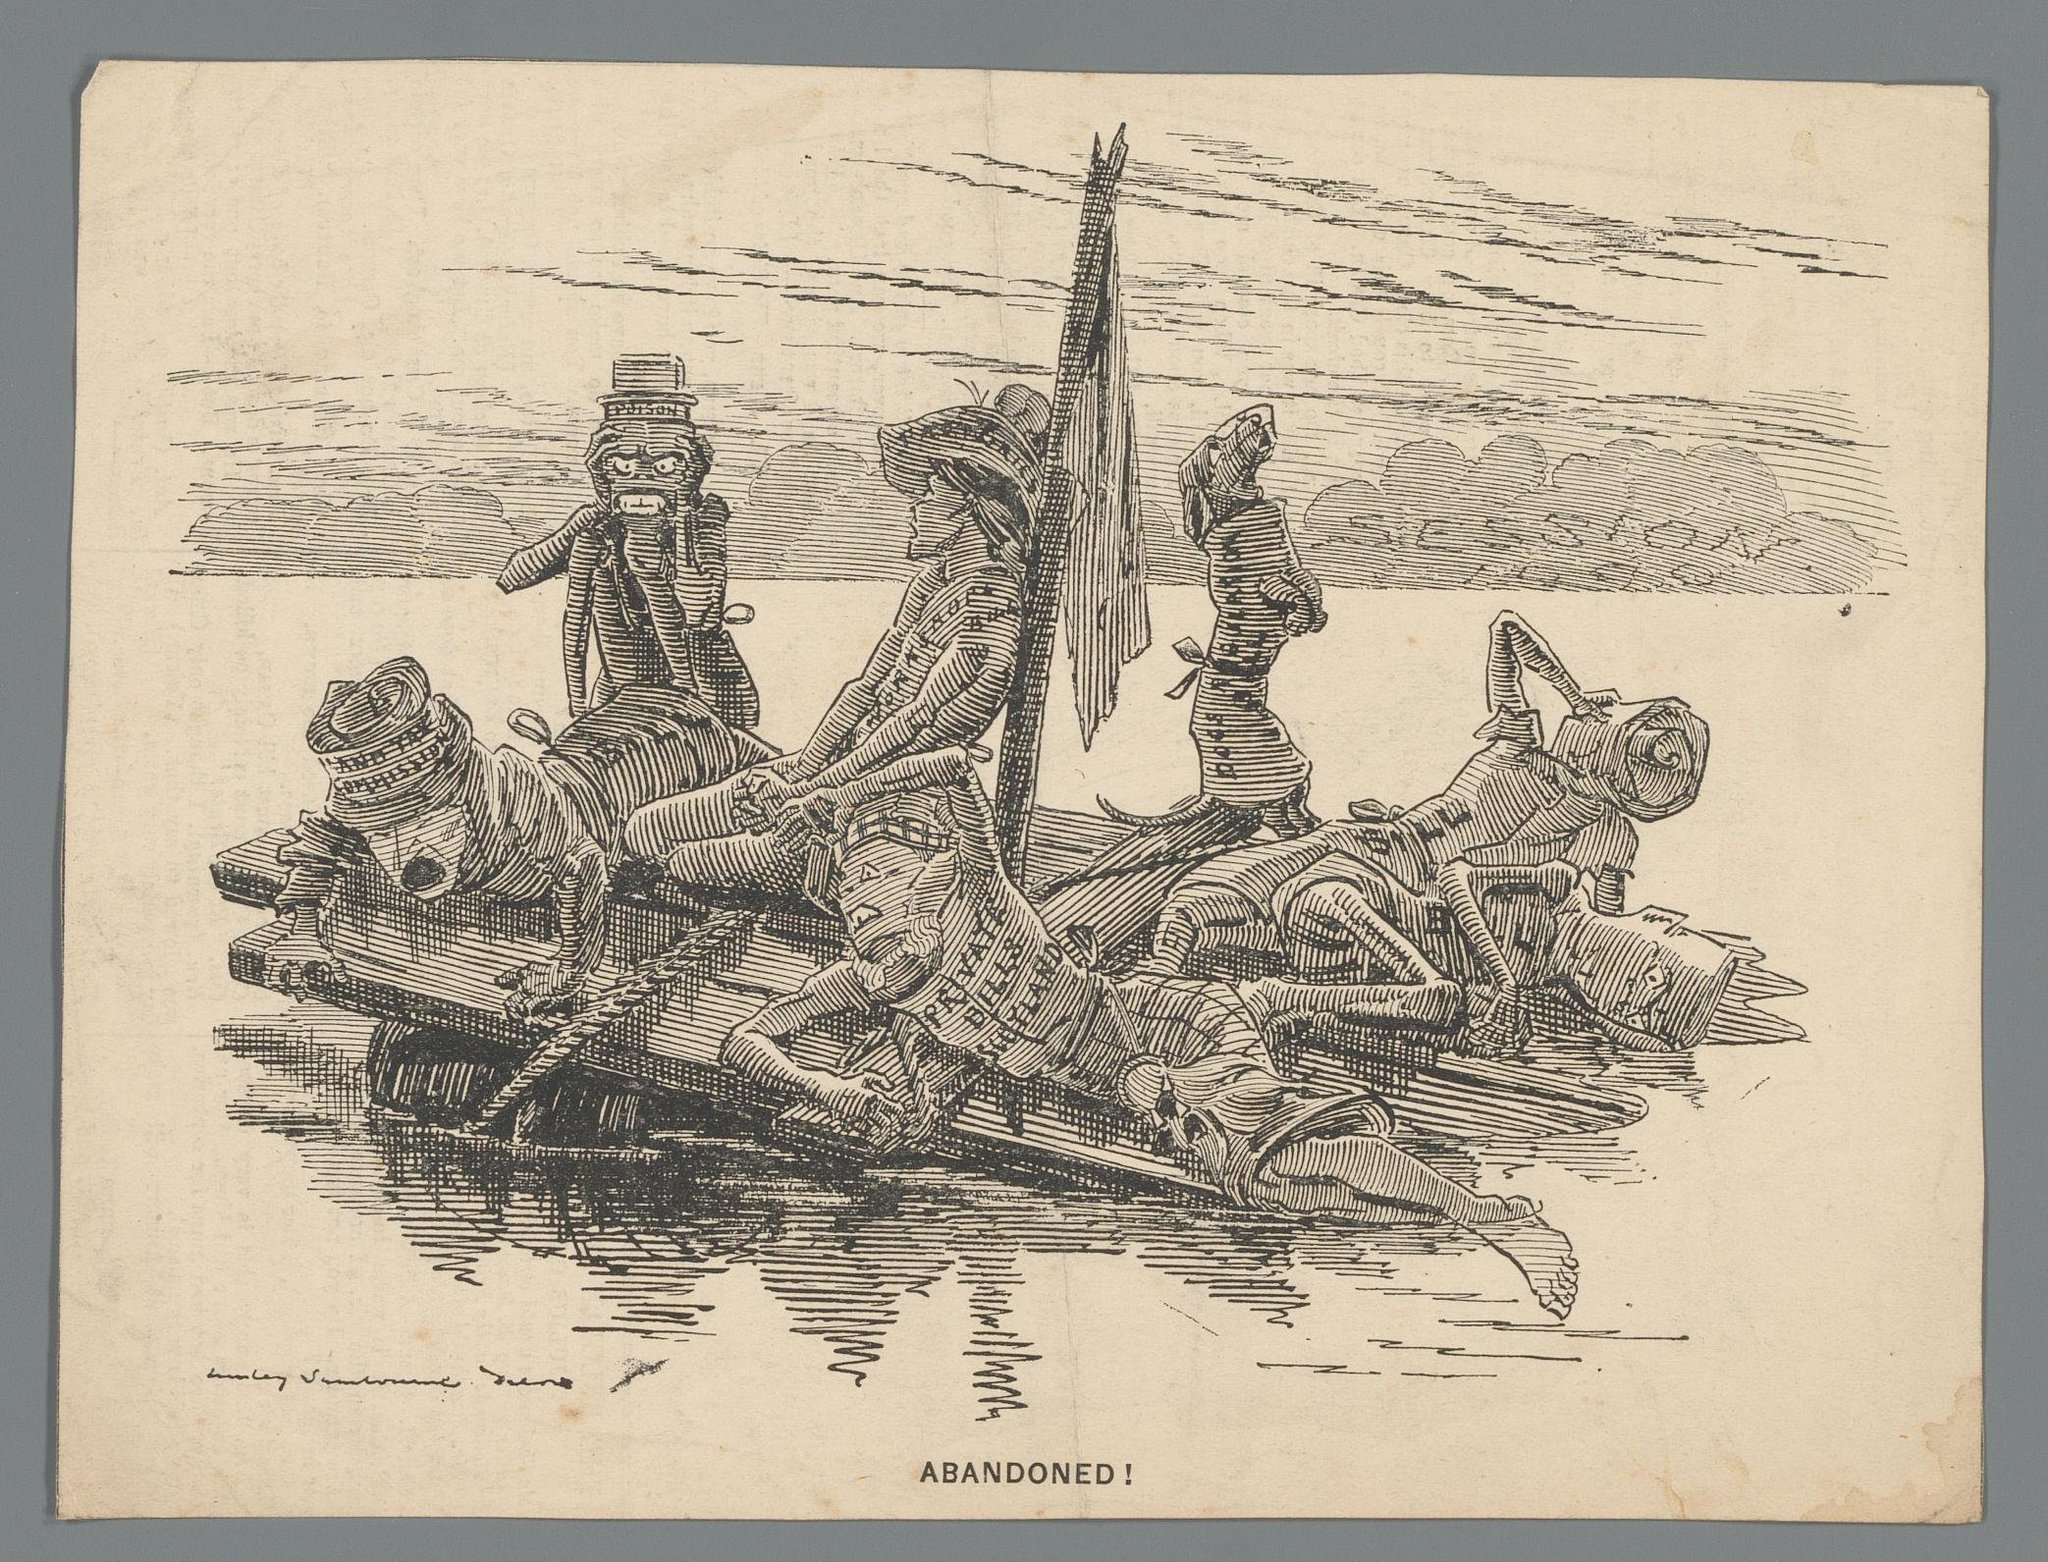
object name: print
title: Schipbreukelingen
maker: edward linley sambourne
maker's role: draughtsman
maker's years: 1844-1910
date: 1896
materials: paper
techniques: line block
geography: england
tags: raft, political caricatures and satires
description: Onbehandelde wetsvoorstellen voorgesteld als schipbreukelingen op een vlot op zee. Spotprent in het Engelse satirische tijdschrift Punch, 1896.